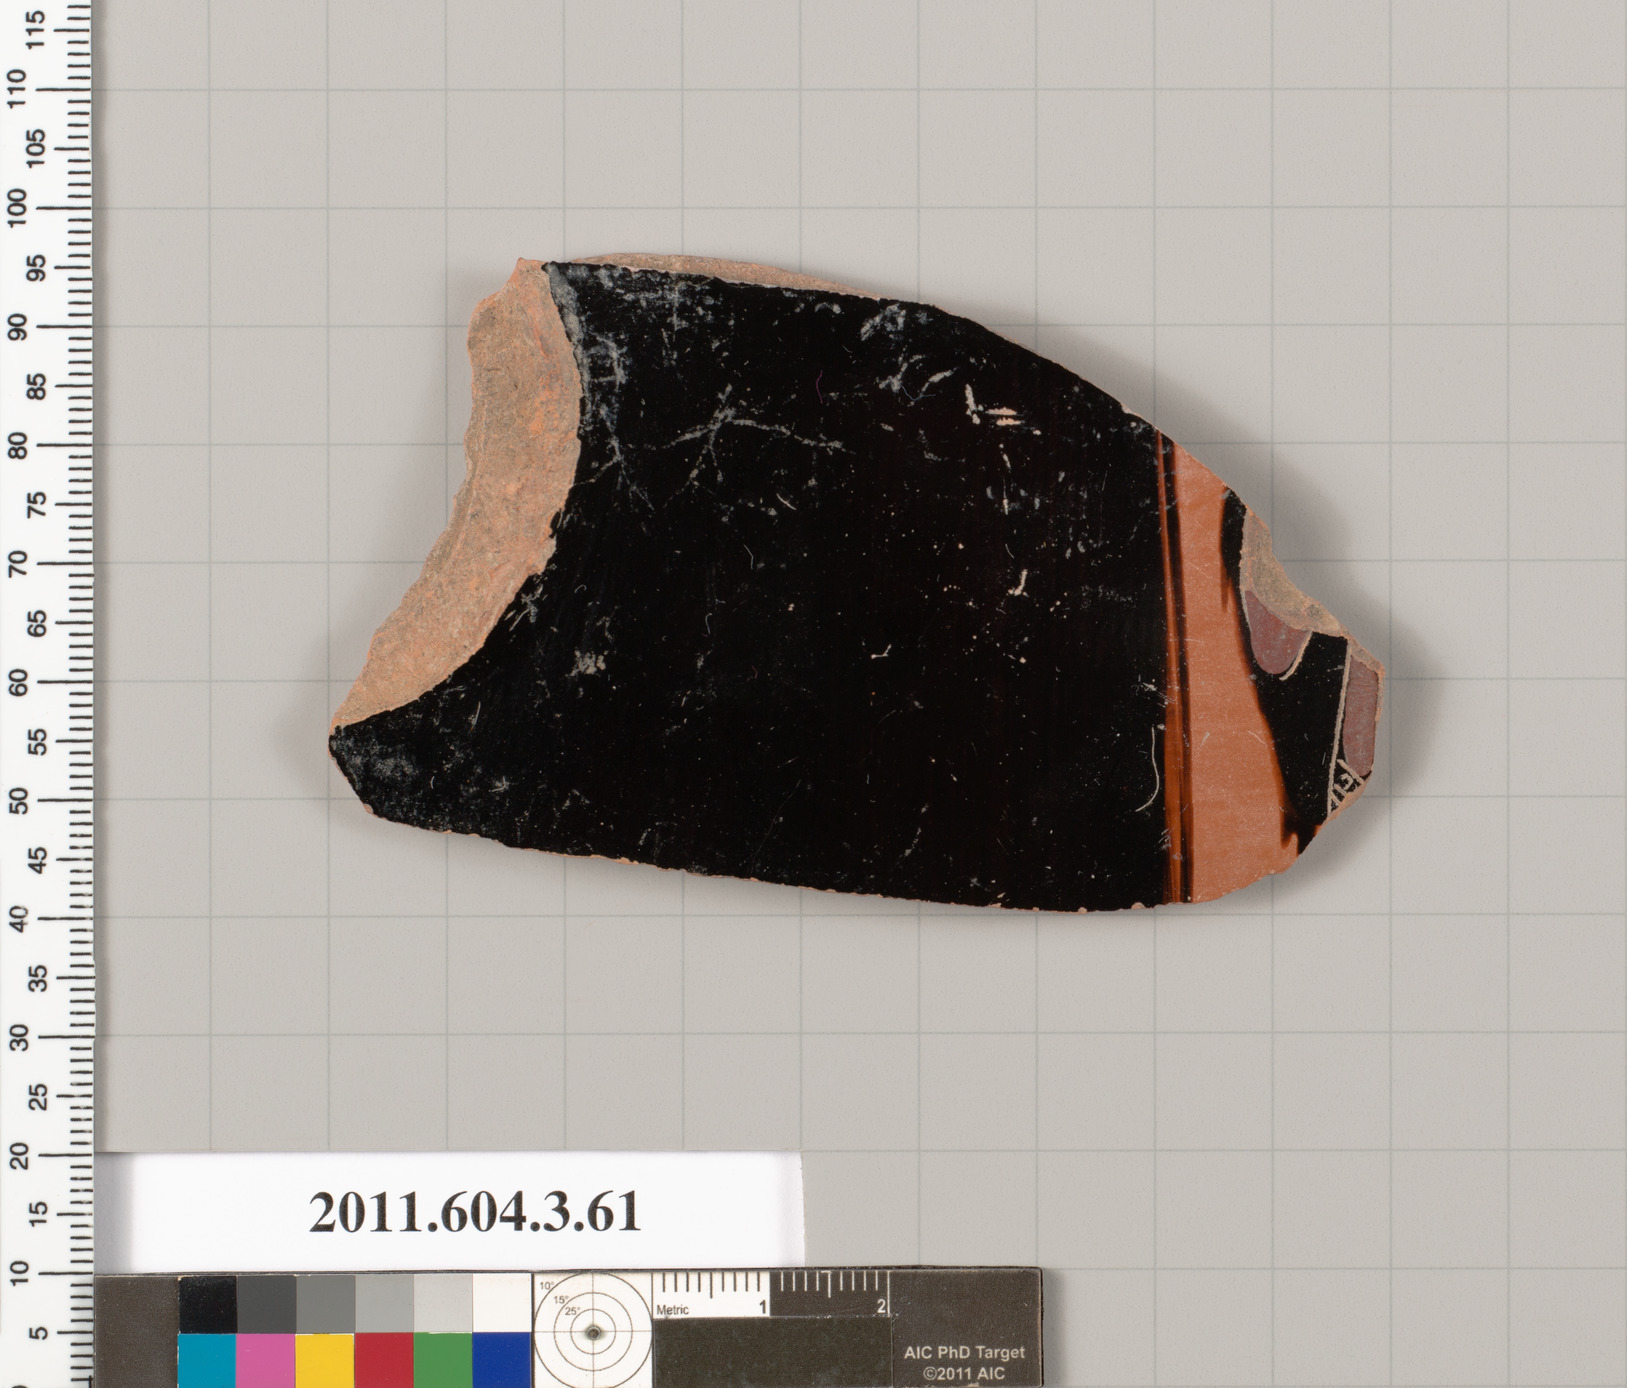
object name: amphora fragment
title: Terracotta fragment of an amphora (jar)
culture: greek, attic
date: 525-501 BCE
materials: terracotta